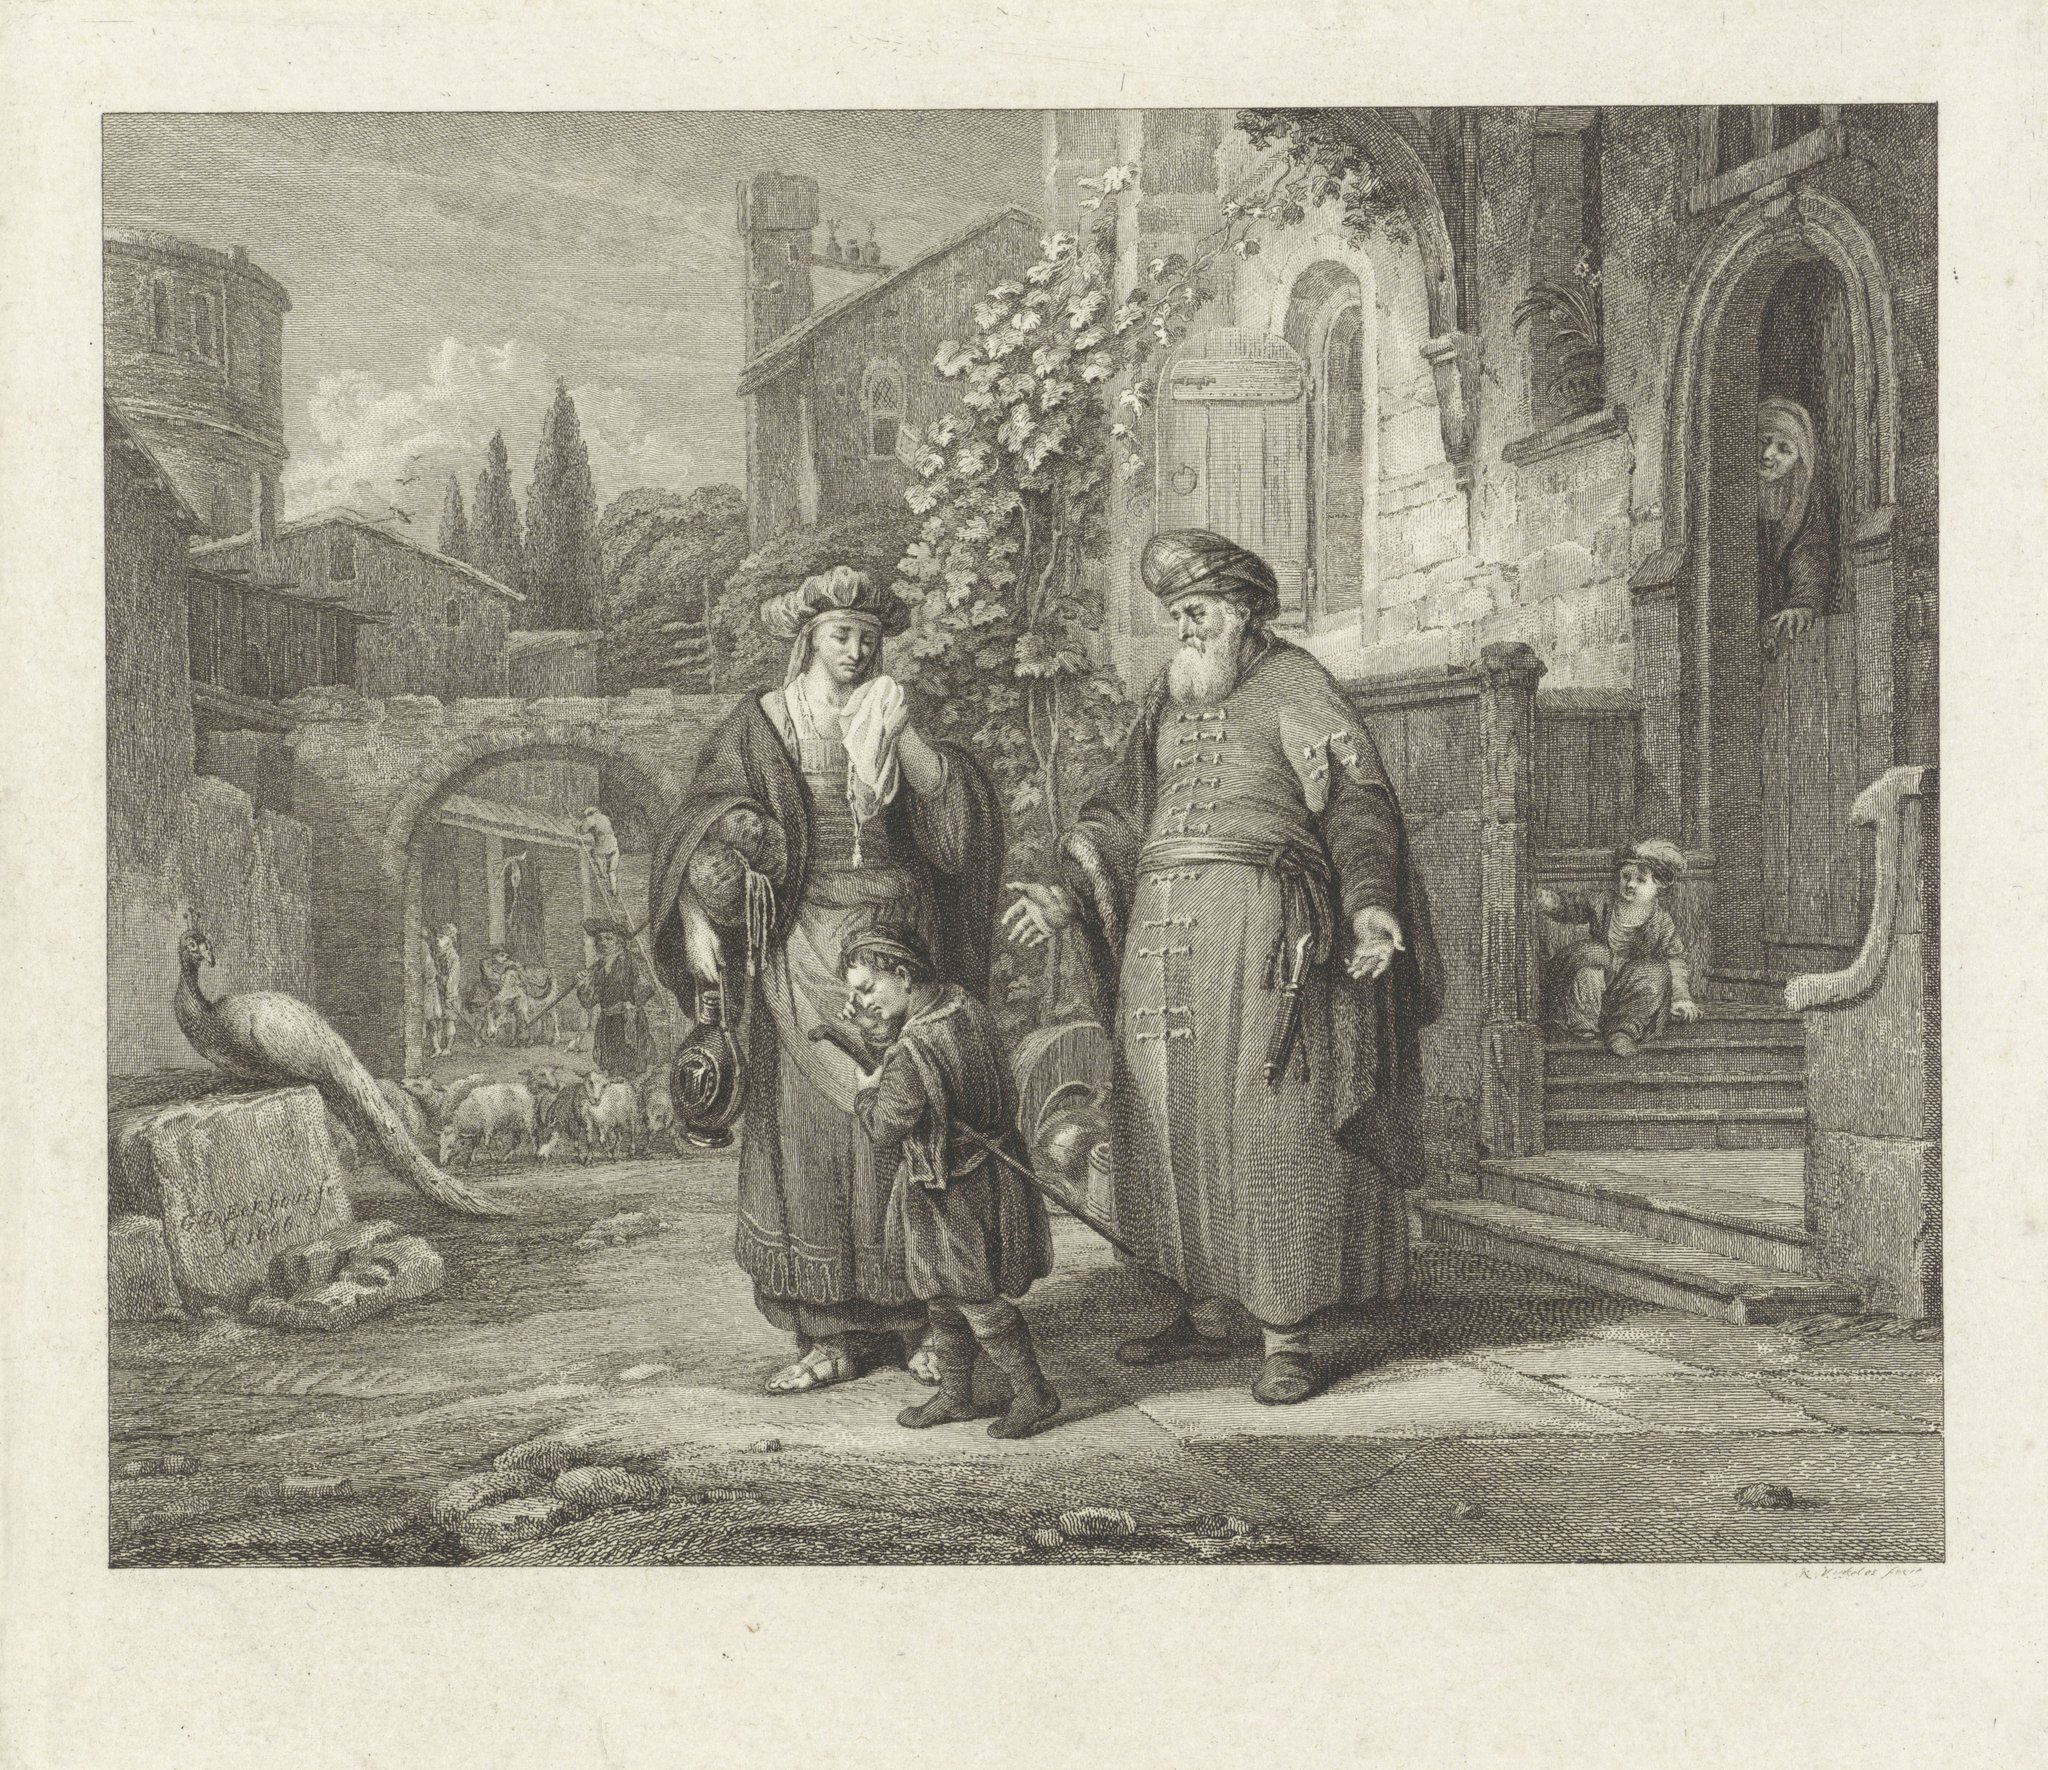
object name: print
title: Hagar en Ismaël door Abraham verstoten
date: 1751-1816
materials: paper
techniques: engraving, etching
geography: amsterdam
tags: the banishment of hagar and ishmael (genesis 21:9-21)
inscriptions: collector's mark: Lugt 2228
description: Abraham staat voor zijn huis en stuurt Hagar en Ismaël weg. Ismaël heeft een wandelstok, Hagar droogt haar tranen met een zakdoek. Achter Abraham staat Sara in de deuropening.